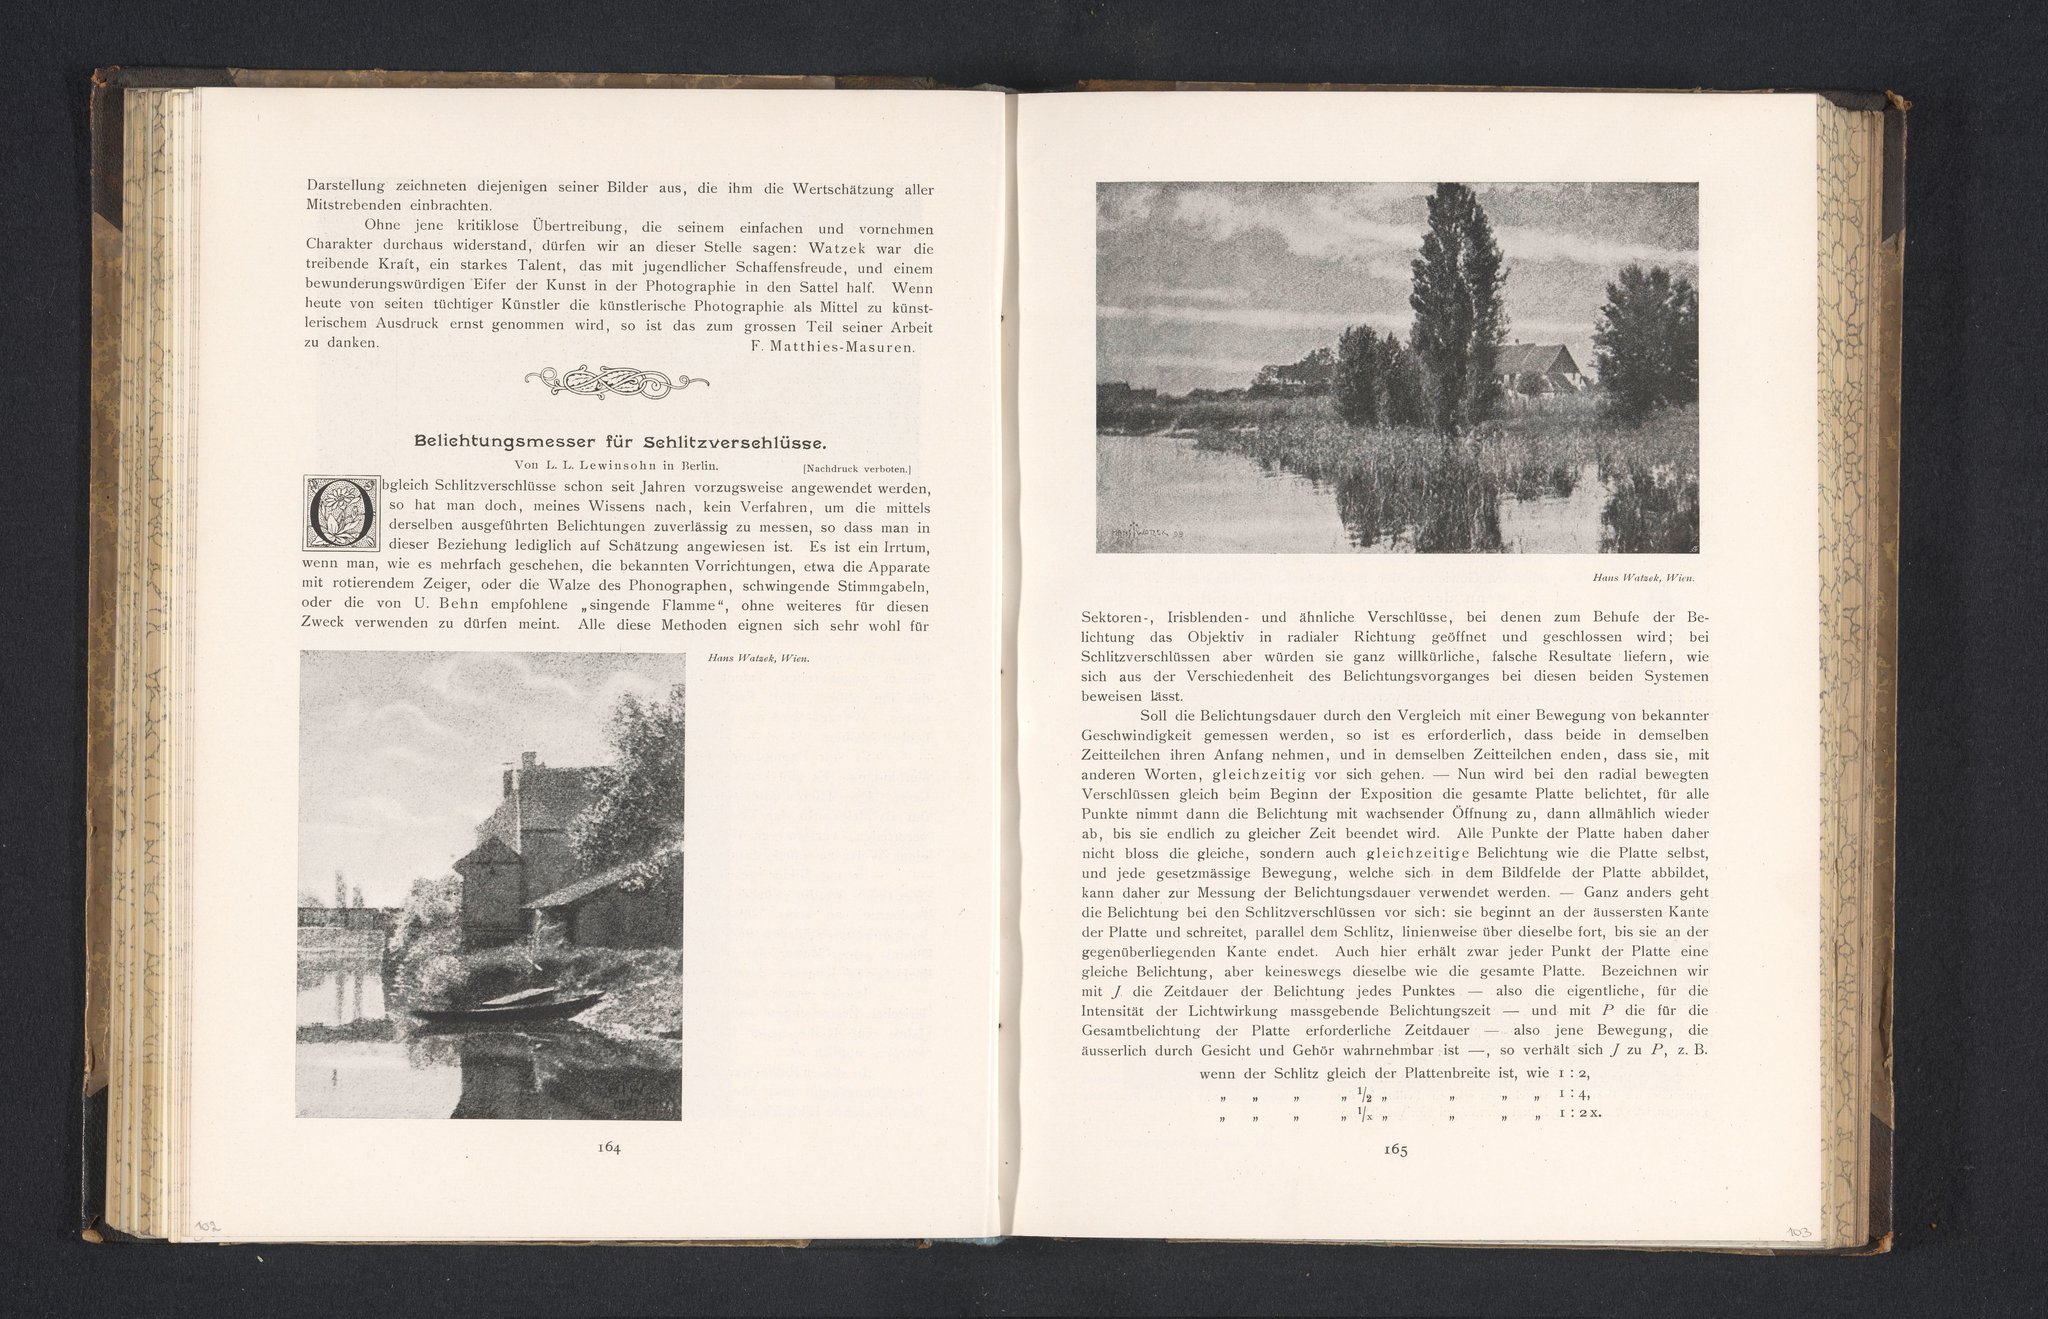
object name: photomechanical print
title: Huis aan het water, met op de voorgrond een roeiboot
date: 1898-1903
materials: paper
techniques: autotype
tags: housing, rowing-boat, canoe, etc.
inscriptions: monogram: ‘AG’